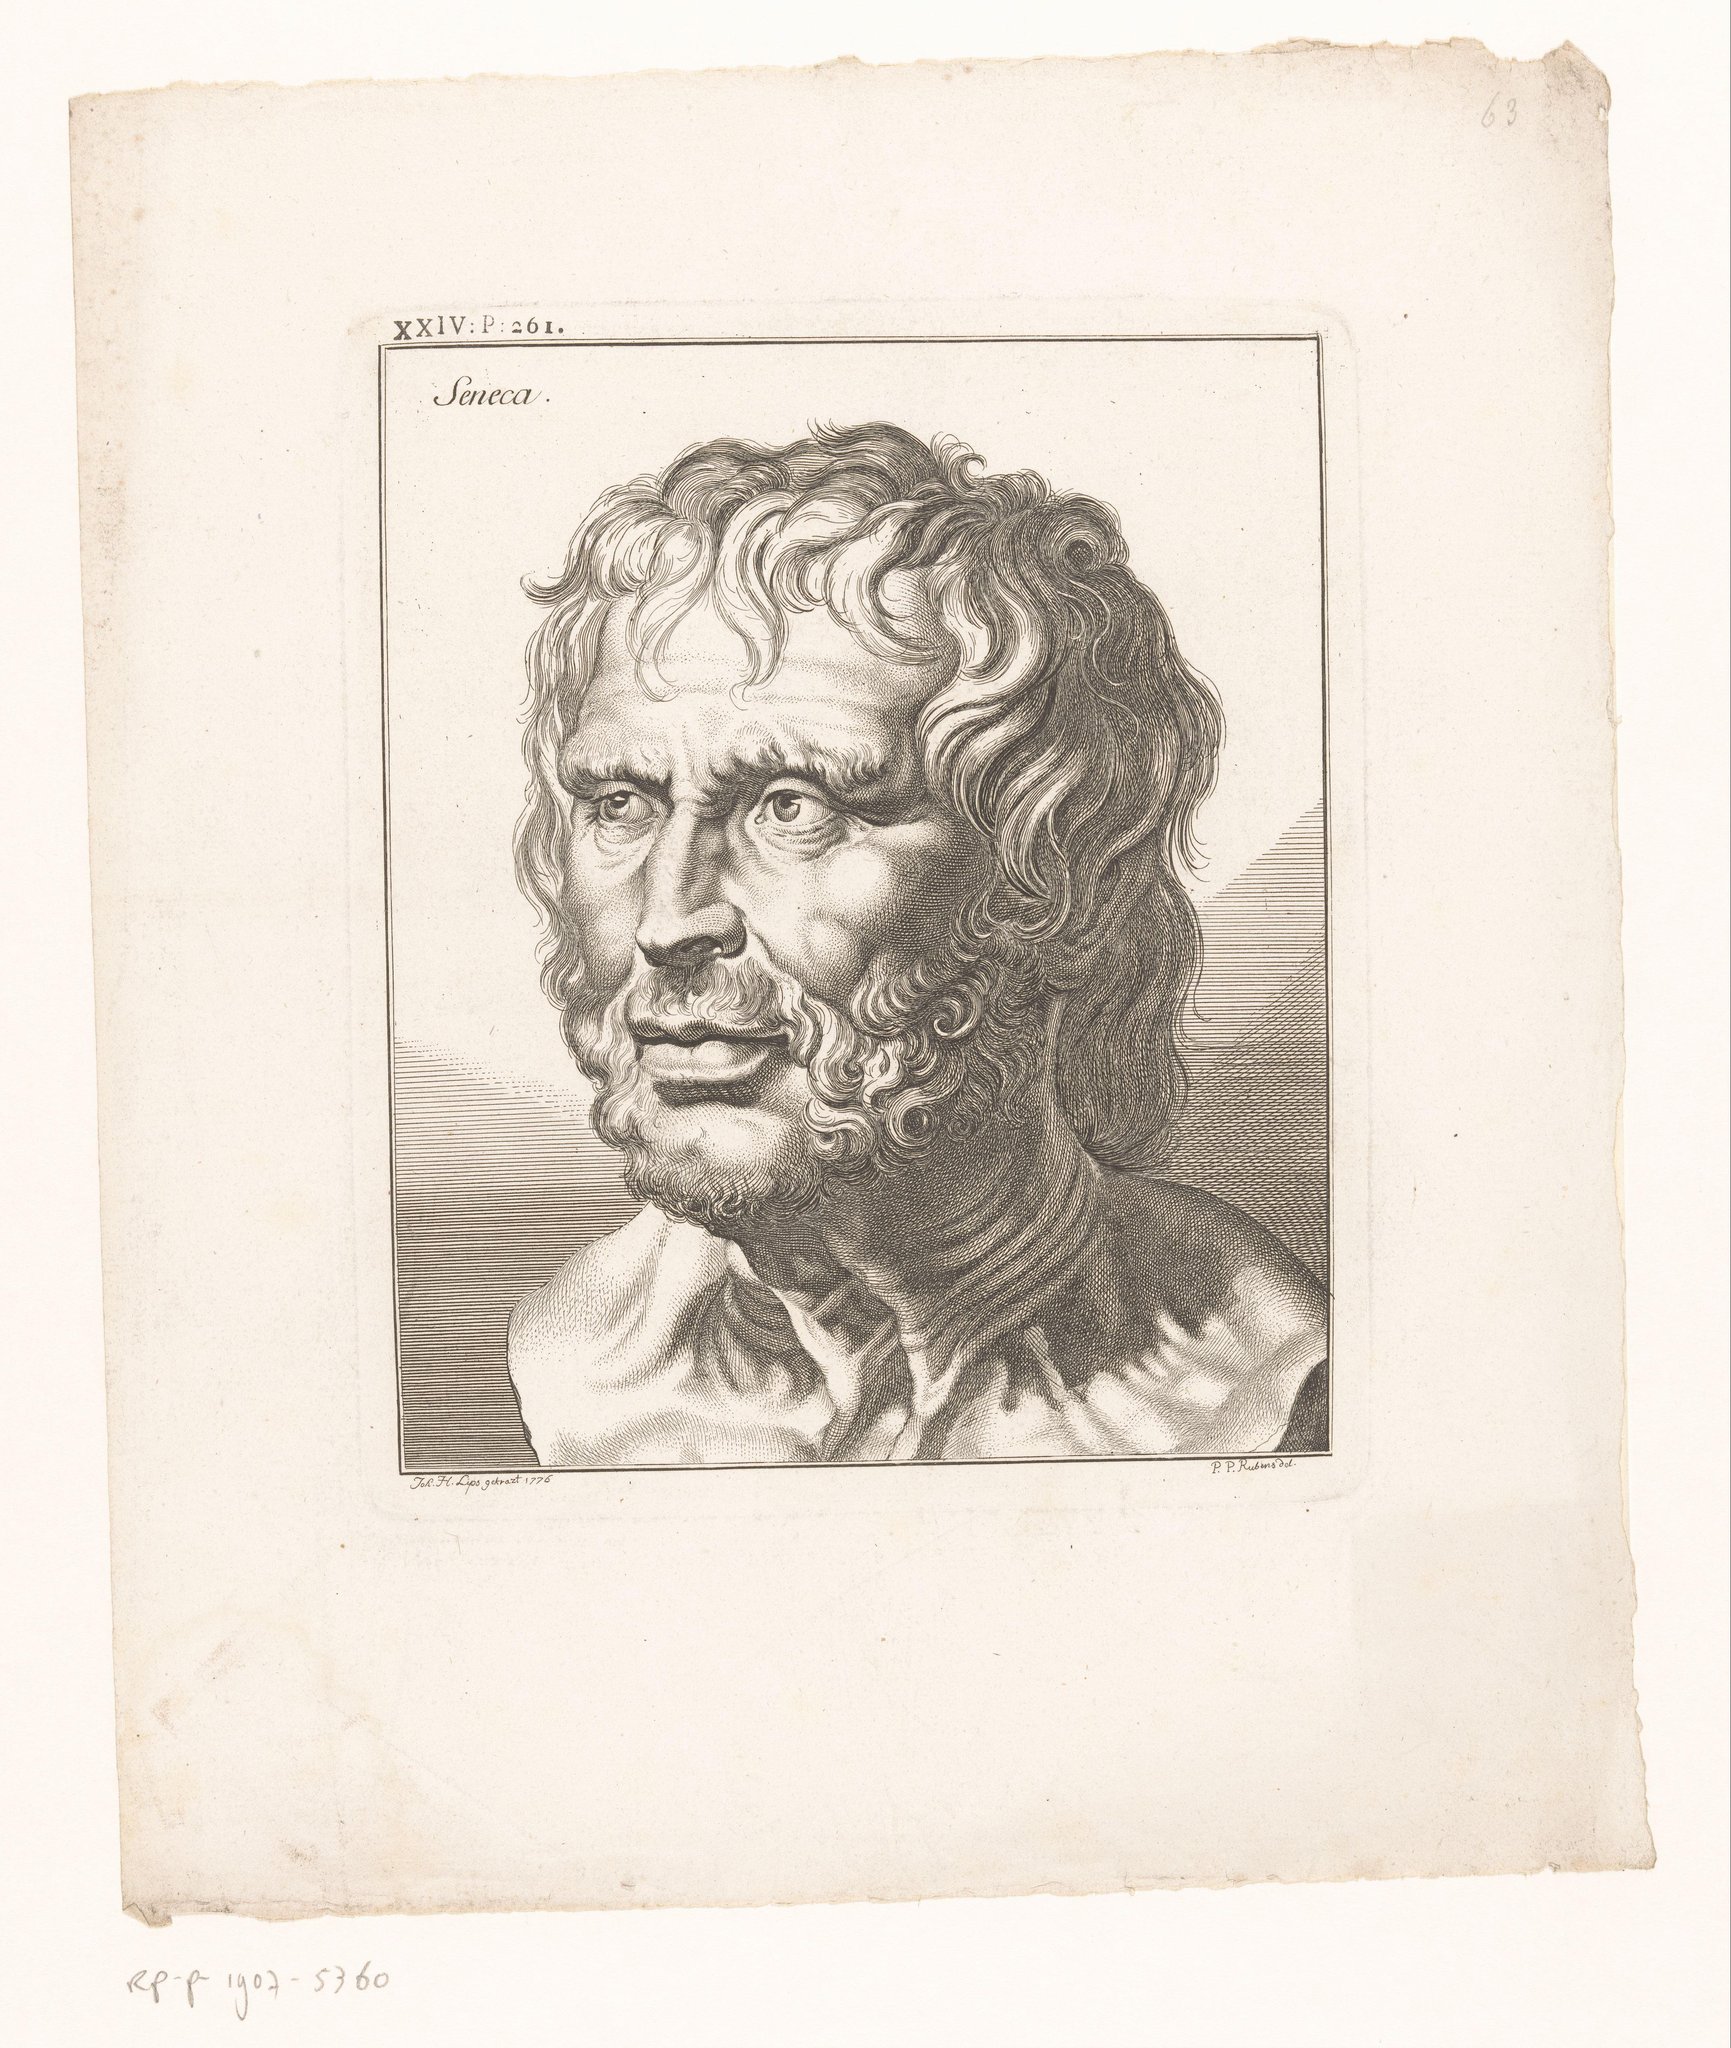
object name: print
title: Portret van Lucius Annaeus Seneca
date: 1776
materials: paper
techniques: etching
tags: lucius annaeus seneca, scholar, philosopher, historical persons, portrait of a writer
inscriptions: collector's mark: Lugt 2228